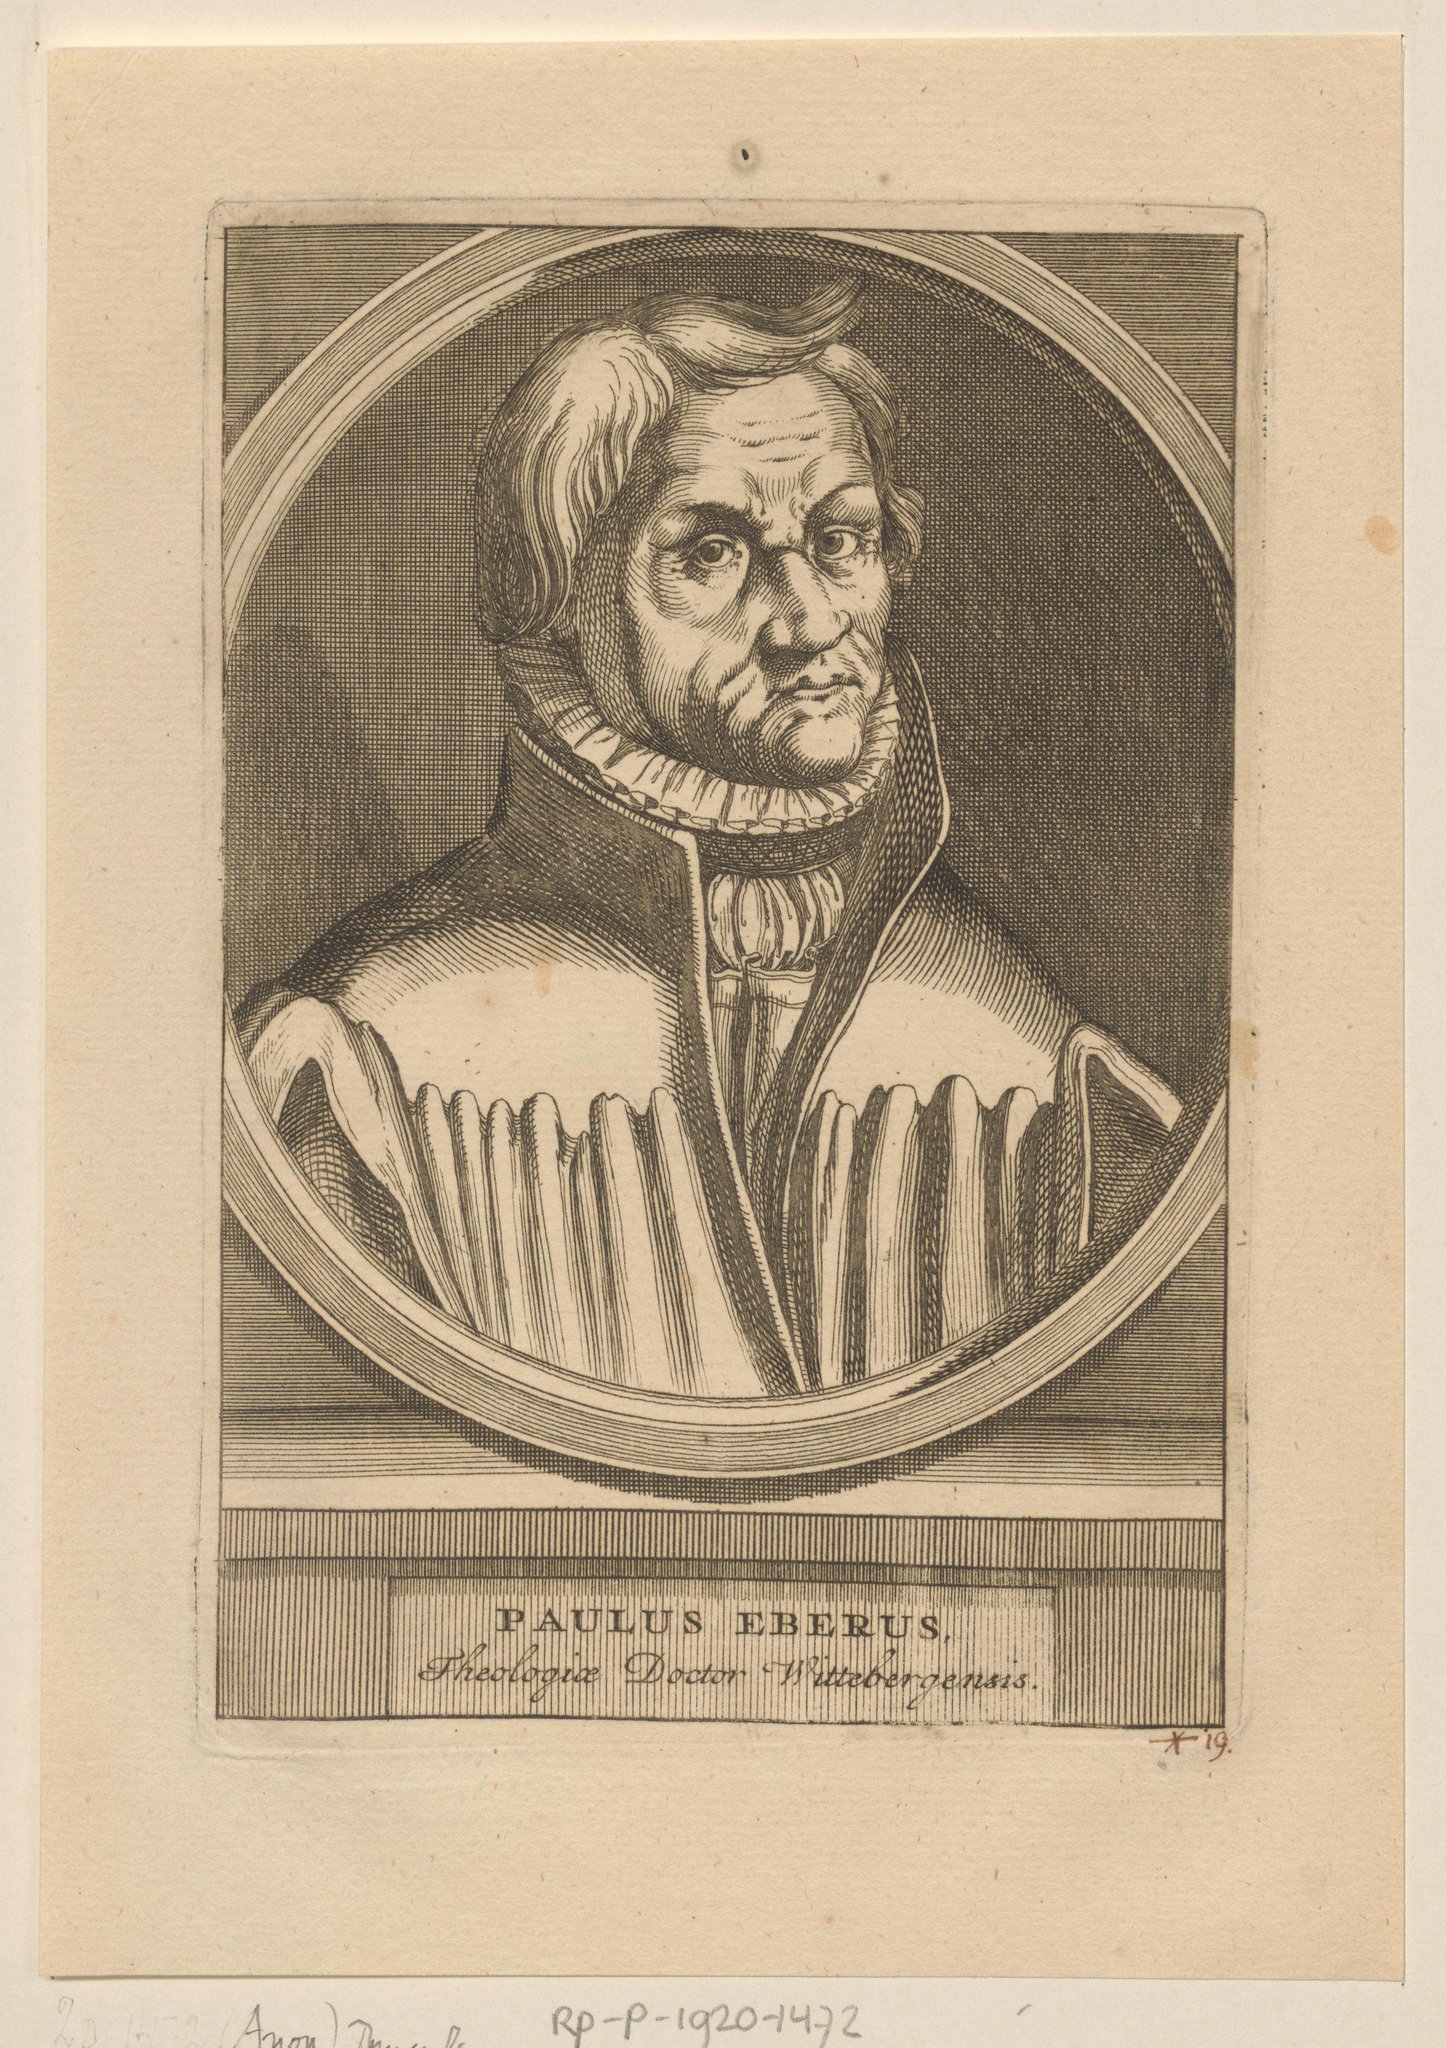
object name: print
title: Le miroir des portraits des premiers reformateurs des eglises protestantes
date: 1690-1729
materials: paper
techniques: etching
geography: leiden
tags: theologian, historical persons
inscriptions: collector's mark: Lugt 2228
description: Prent waarschijnlijk uit een editie van: Le miroir des portraits des premiers reformateurs des eglises protestantes. Leiden: Pieter van der Aa, [1690-1729]. Eerdere staat gebruikt in serie uit 1599 en publicaties uit 1602 en 1604.